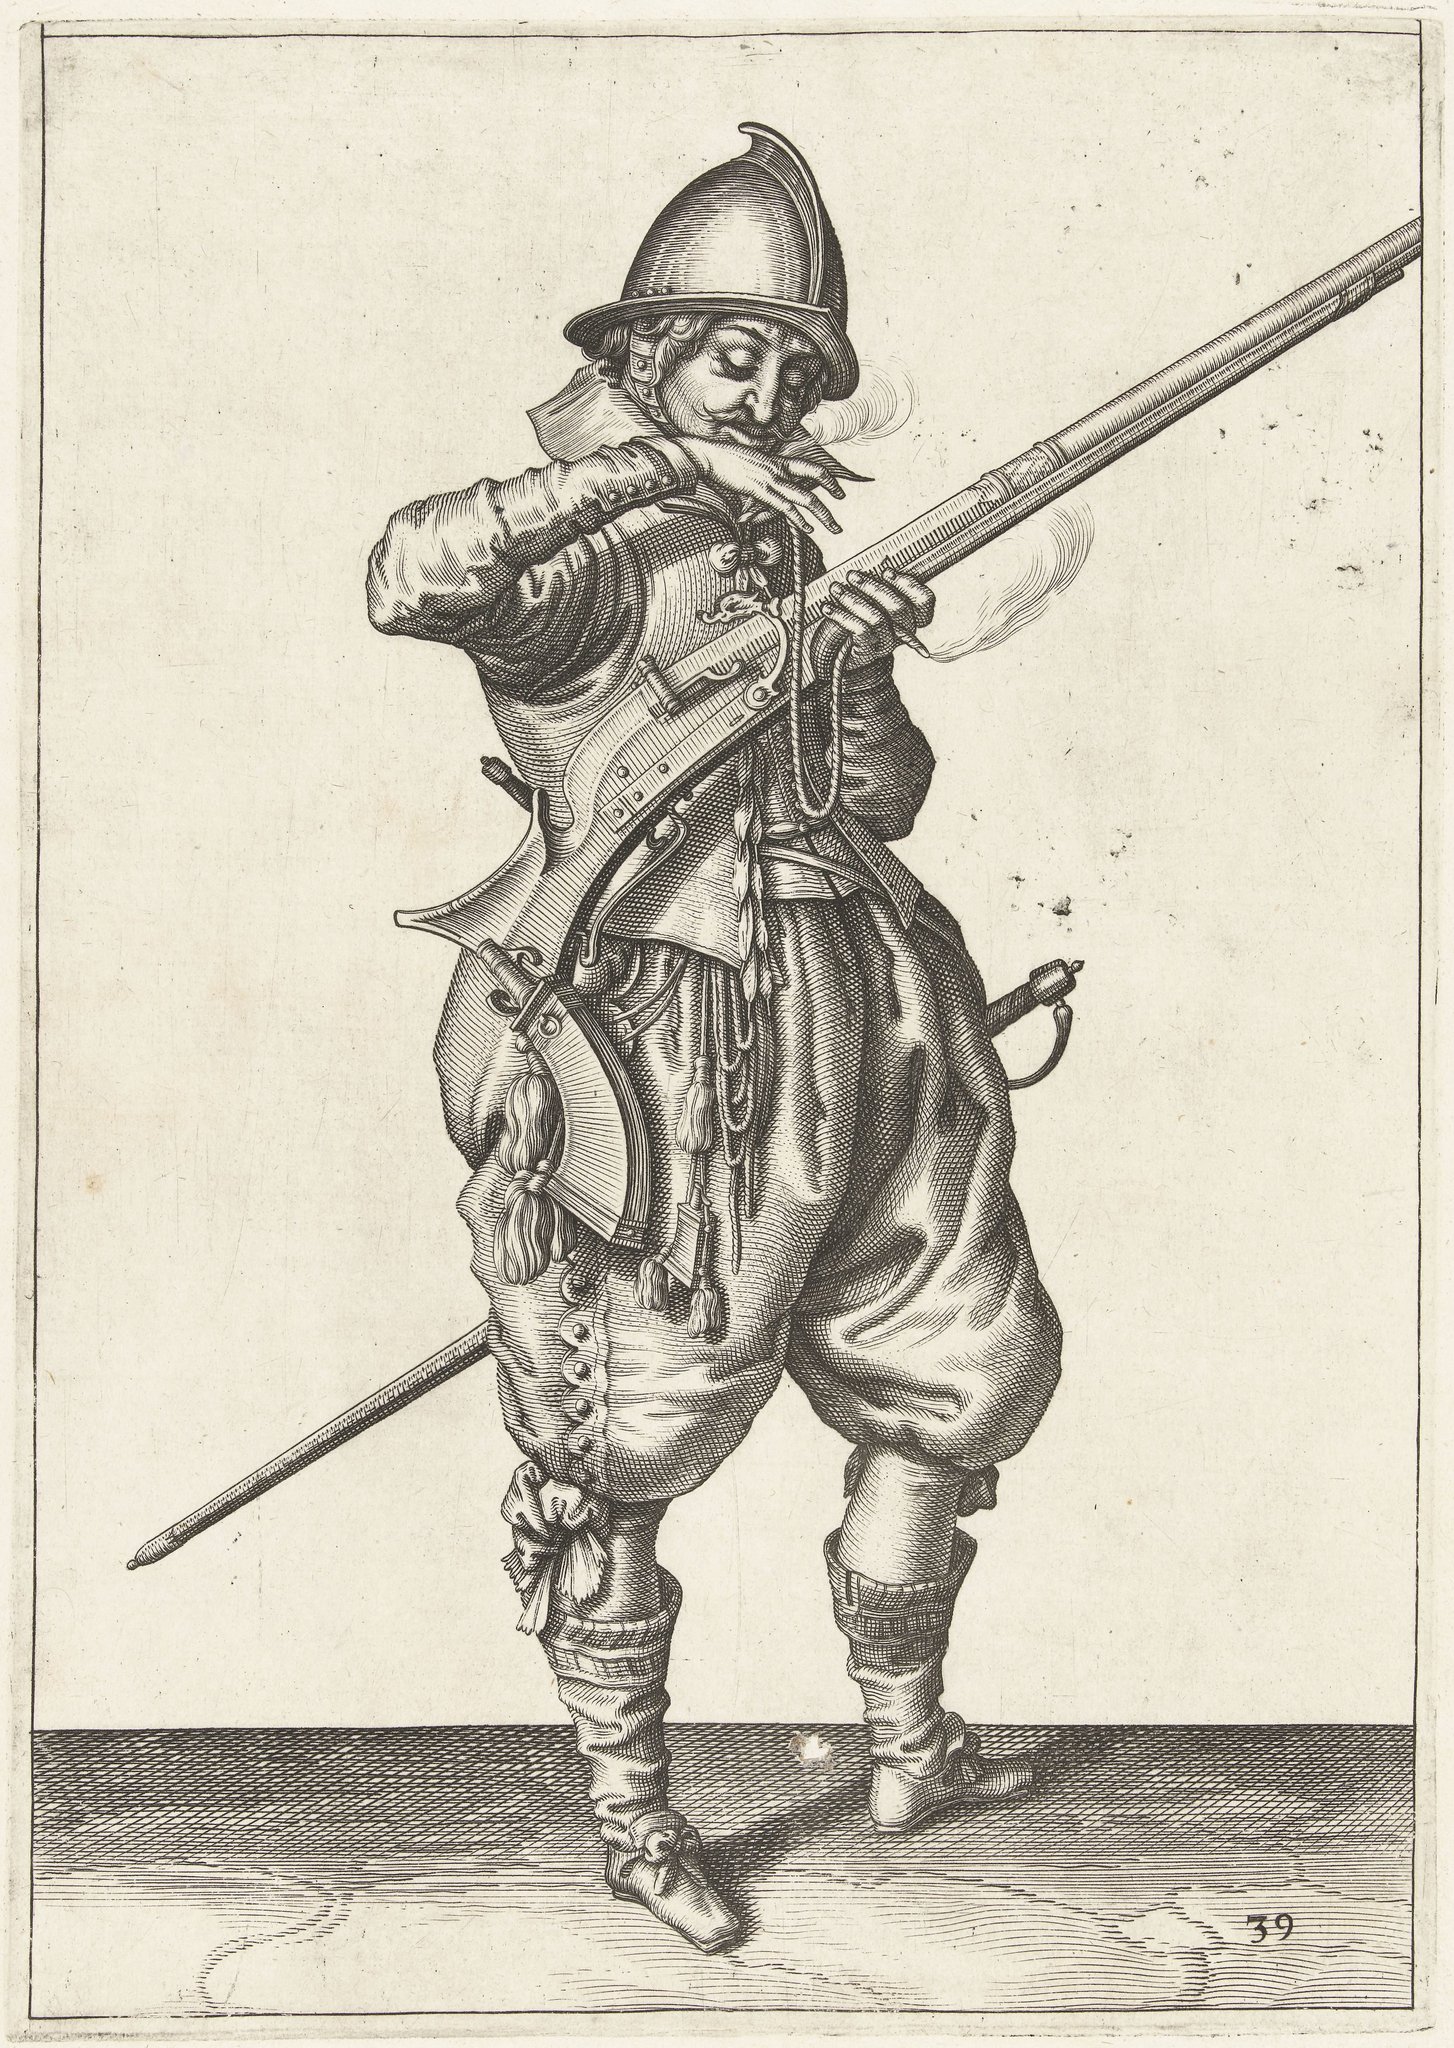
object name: print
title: Soldaat op wacht met een roer die zijn lont naar zijn mond brengt om hem schoon te blazen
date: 1597-1607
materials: paper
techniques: engraving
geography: netherlands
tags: manoeuvre ~ military training, firearms: rifle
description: Een soldaat op wacht, ten voeten uit, naar rechts, die een roer (een bepaald type vuurwapen) met zijn linkerhand vasthoudt. Met zijn rechterhand brengt hij een brandende lont naar zijn mond om hem schoon te blazen. Het gaat dus om dezelfde positie als degene die op de zesde prent van de serie getoond wordt. Deze prent is onderdeel van de reeks van 42 genummerde prenten van roerschutters uit de Wapenhandelinghe.